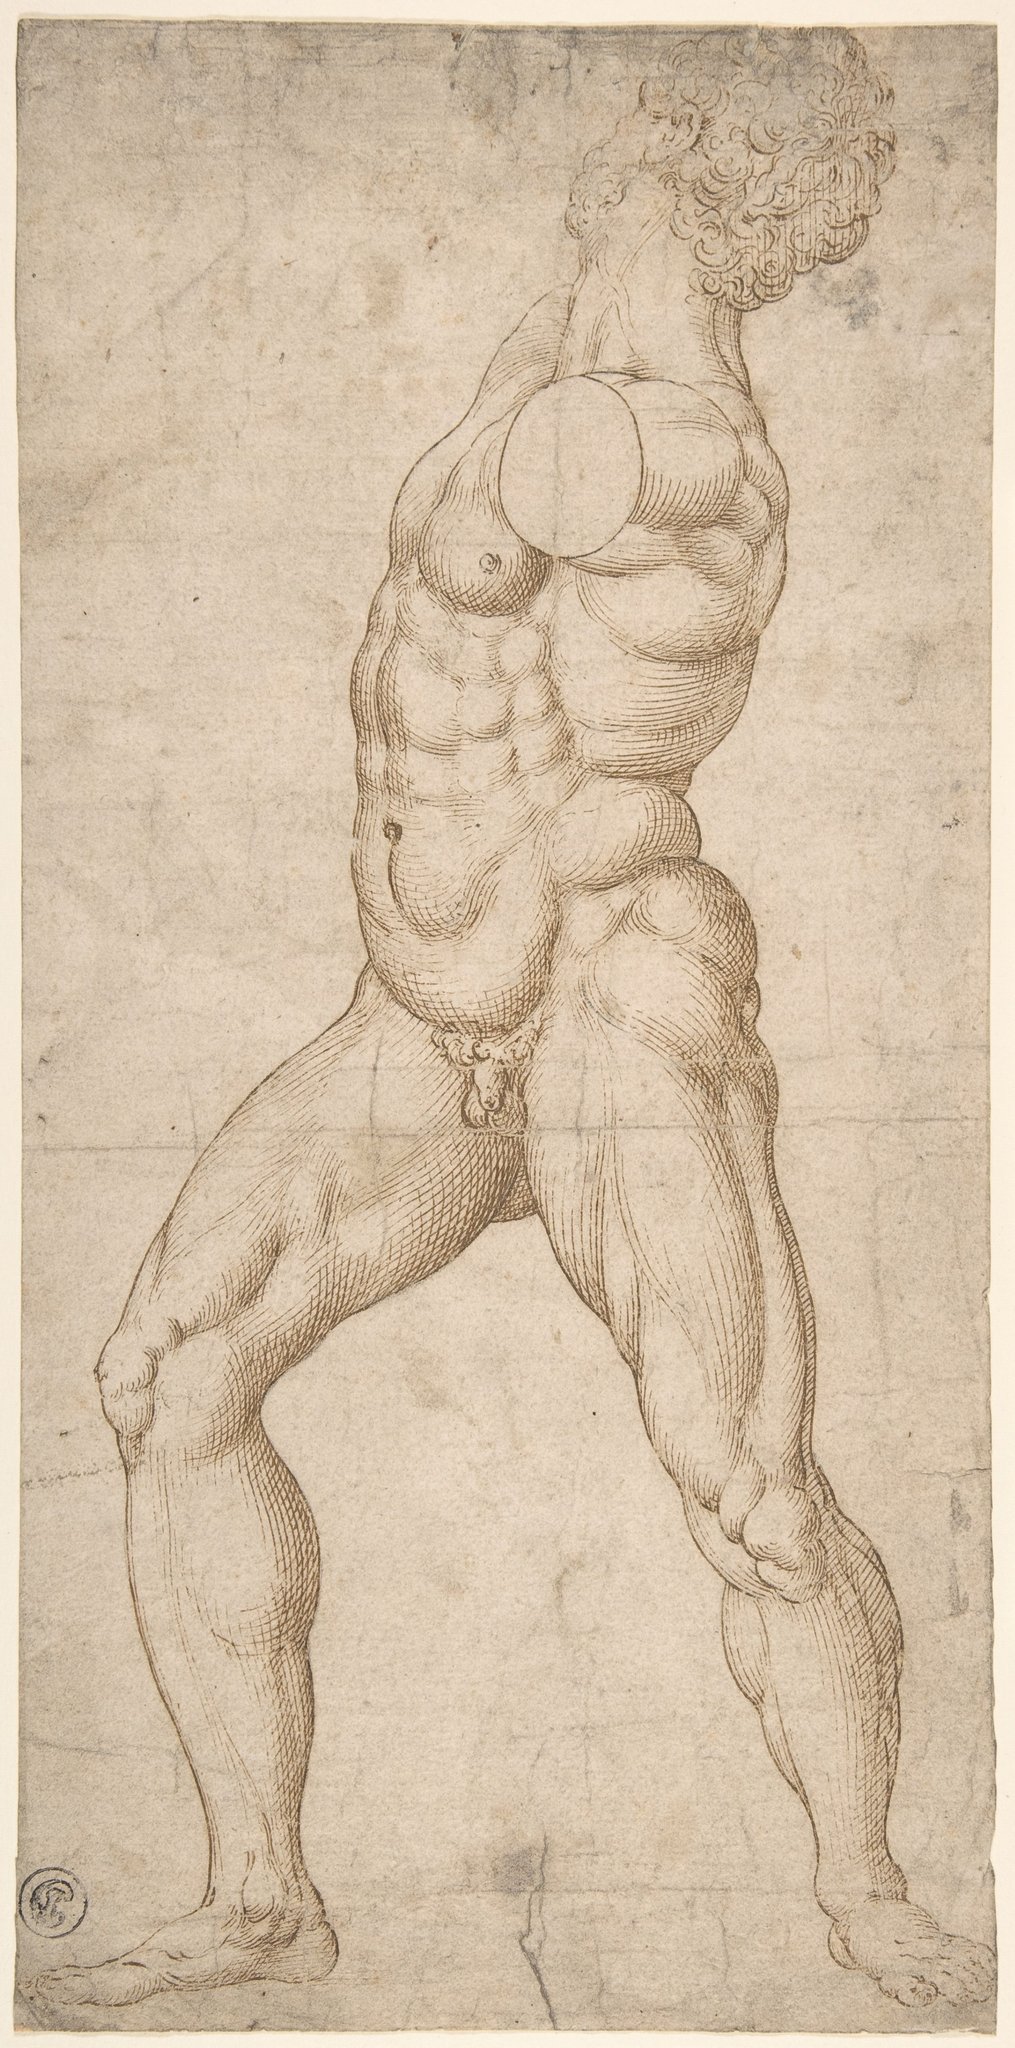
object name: drawing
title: Study of a Standing Male Nude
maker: anonymous, netherlandish, 16th century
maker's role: artist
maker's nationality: netherlandish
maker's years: 1500-1600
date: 1501-1600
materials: chalk, ink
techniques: pen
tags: male nudes